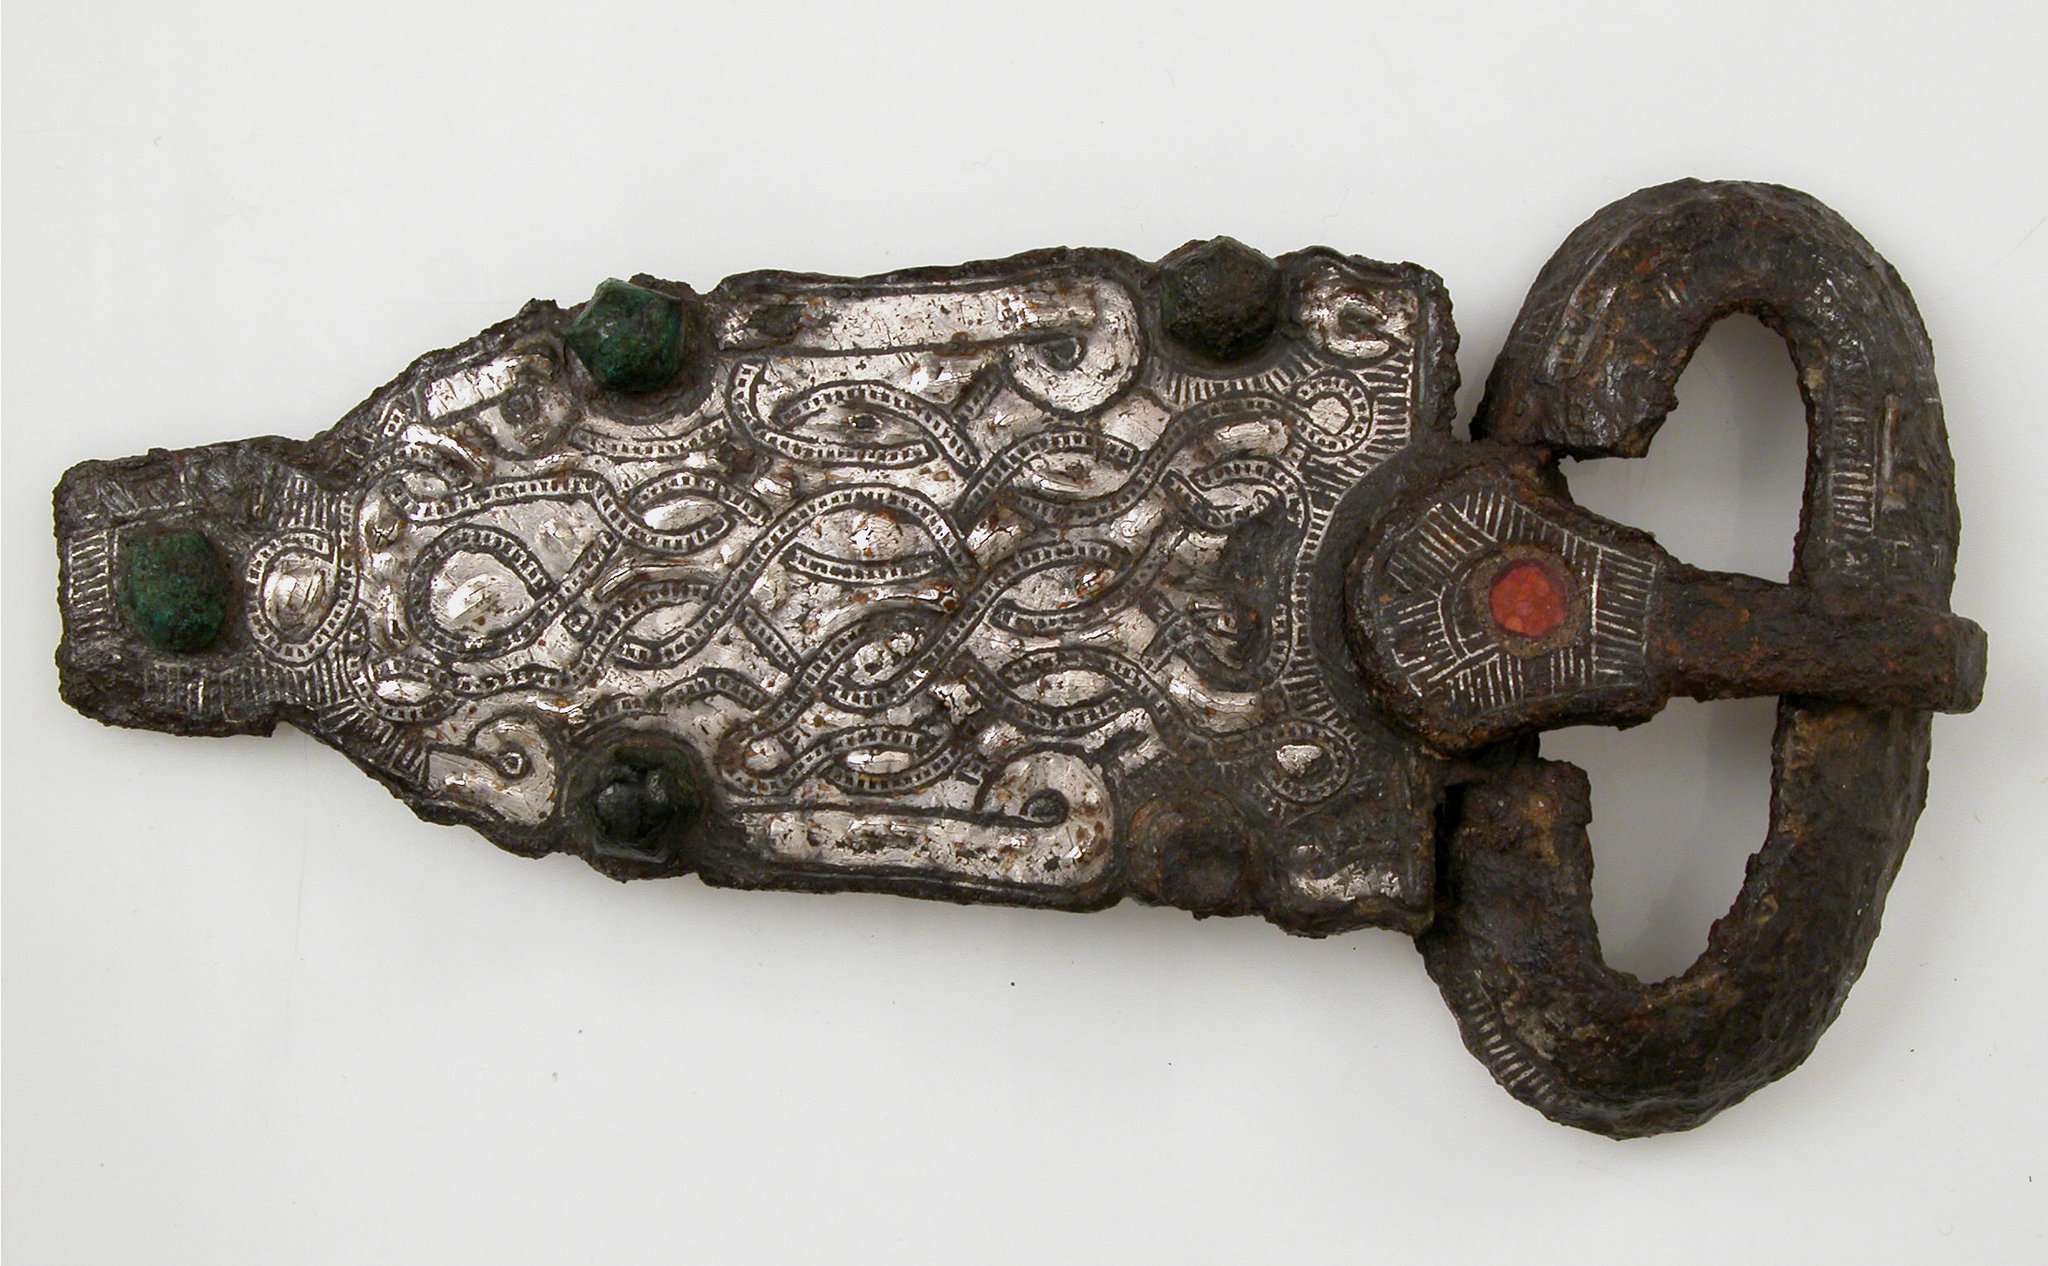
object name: belt buckle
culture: frankish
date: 601-700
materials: gemstone, iron, niello, silver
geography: france